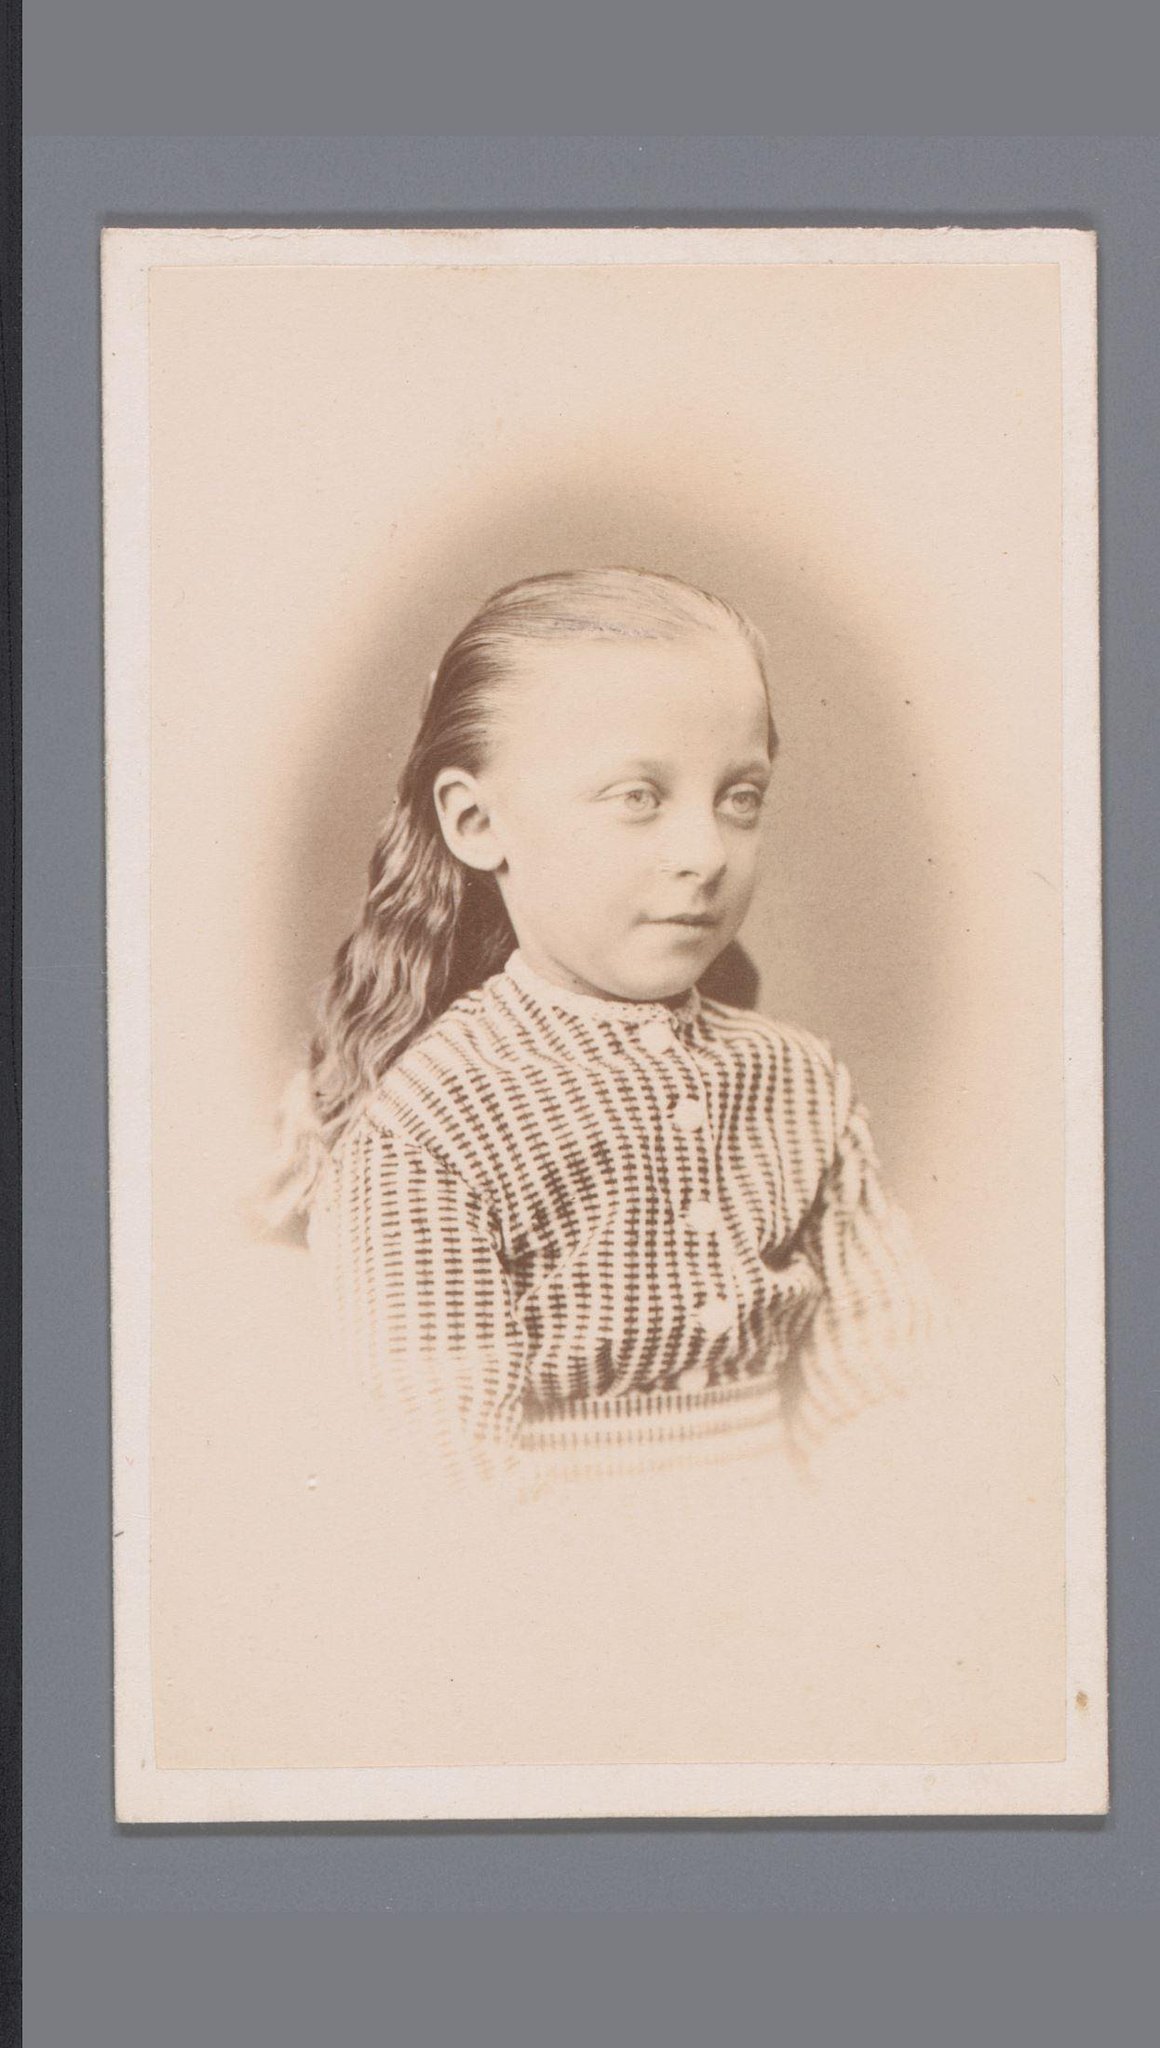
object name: carte de visite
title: Portret van een onbekend meisje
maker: august roesler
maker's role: fotograaf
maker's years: 1837-1896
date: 1862-1896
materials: cardboard, paper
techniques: albumen print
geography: stockholm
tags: historical persons, girl (child between toddler and youth)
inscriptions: inscription: ‘AUGUST ROESLER/ Drottninggatan No. 23/ STOCKHOLM/ samma hus som/ Apotheket Morian.’